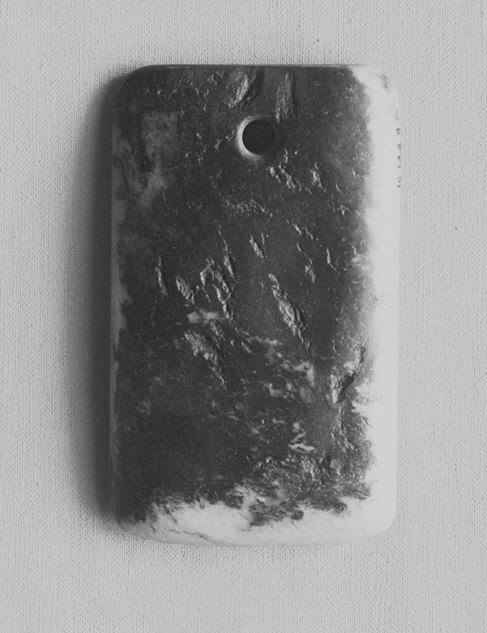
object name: fragment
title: Fragment of a blade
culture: chinese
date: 2200-1600 BCE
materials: jade